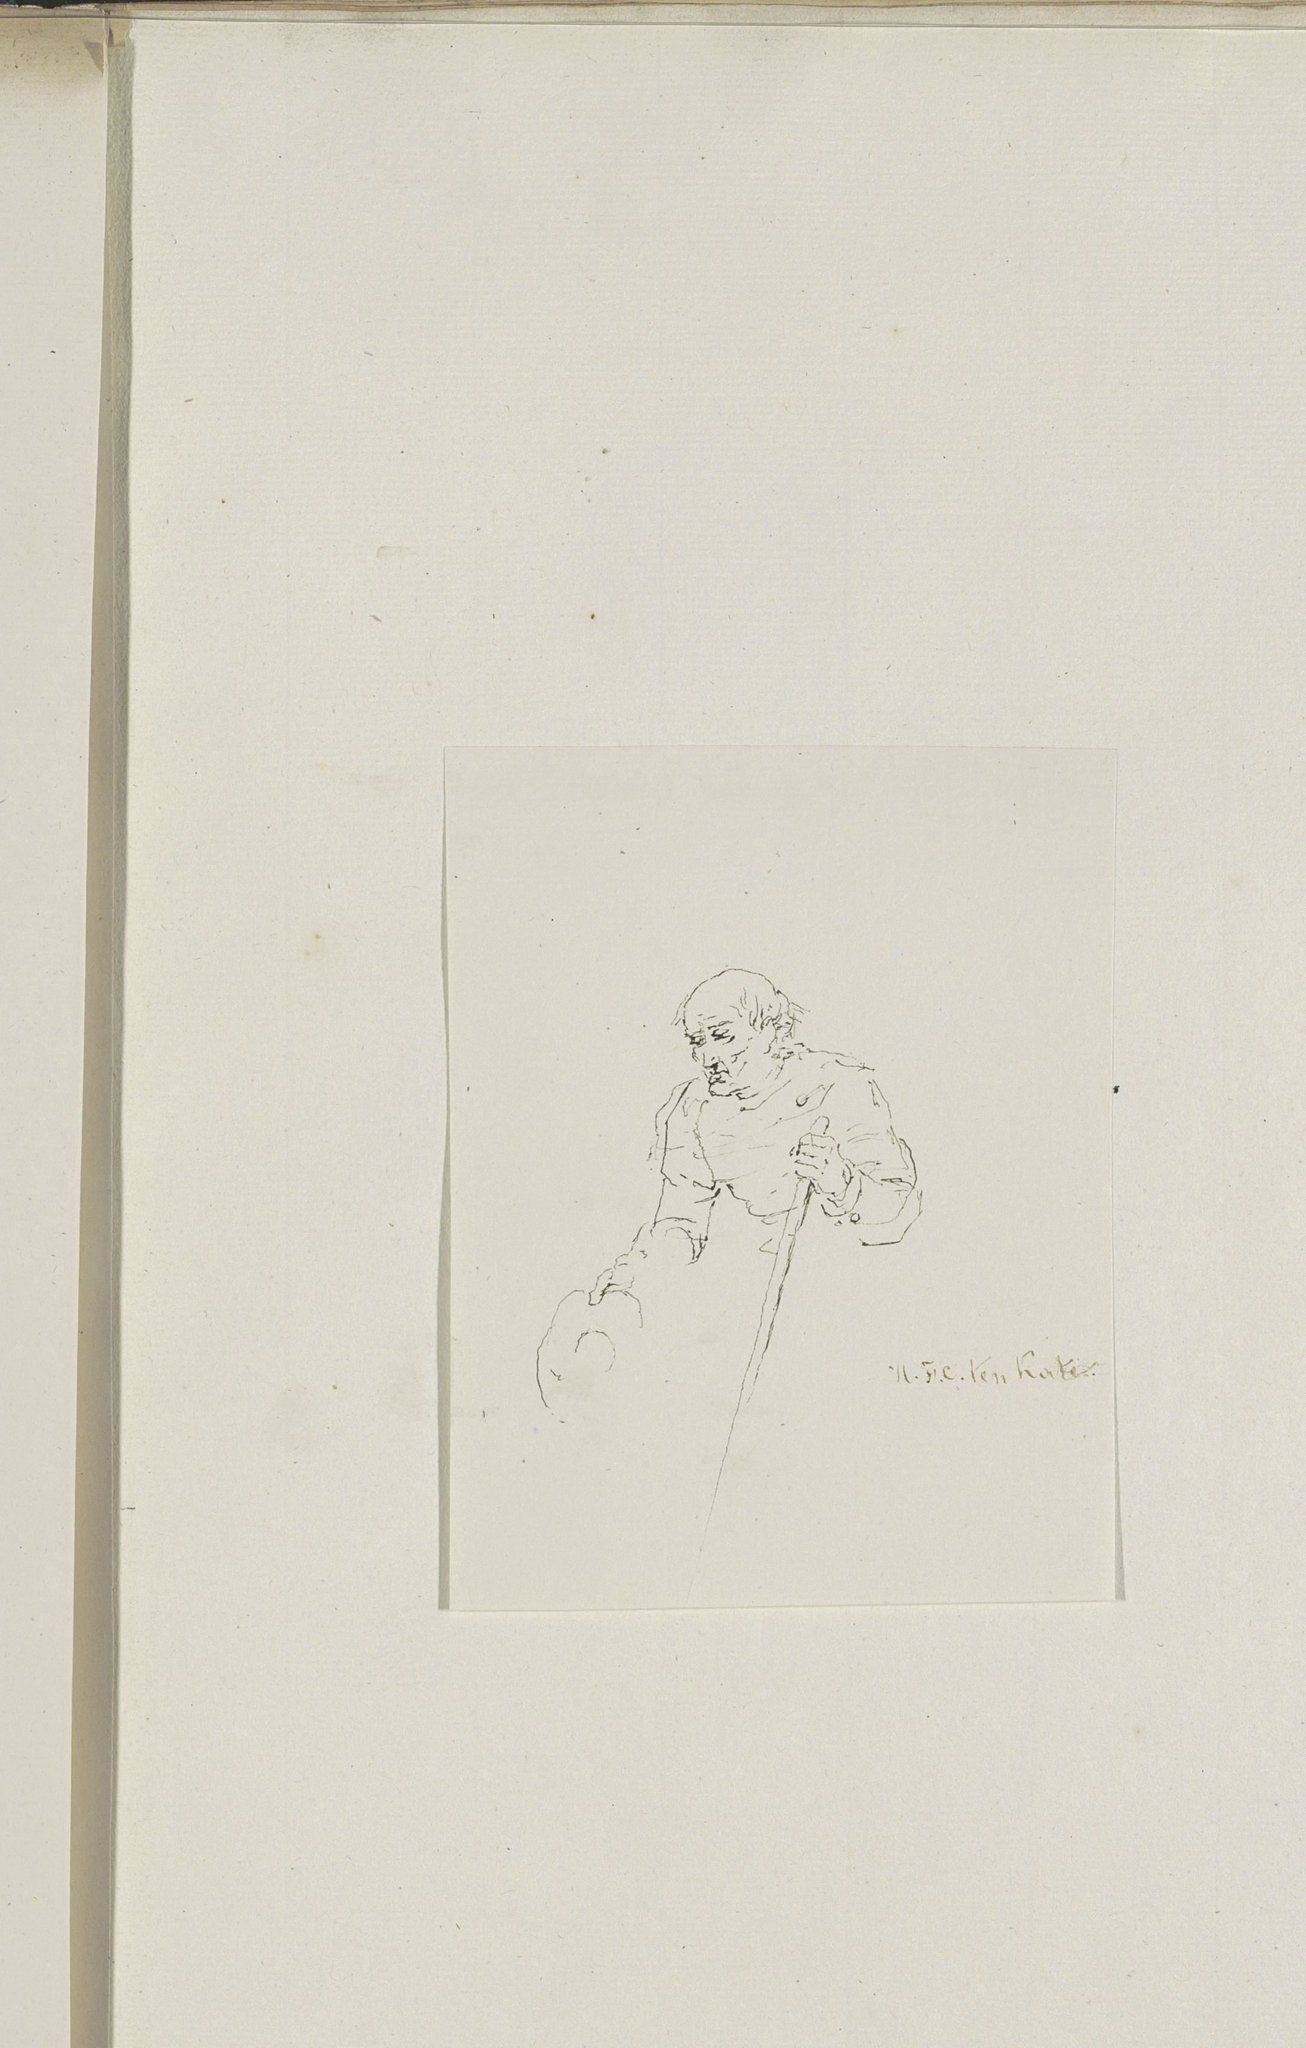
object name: album leaf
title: Man met stok die zijn hoed ophoudt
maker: herman frederik carel ten kate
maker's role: draughtsman, painter, print maker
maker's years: 1822-1891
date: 1843-1864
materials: ink, paper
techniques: pen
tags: walking-stick, staff, beggar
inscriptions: signature: ‘H.F.C. ten Kate.’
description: Vermoedelijk een bedelaar. Blad 3 recto uit een verzamelalbum met 32 bladen.